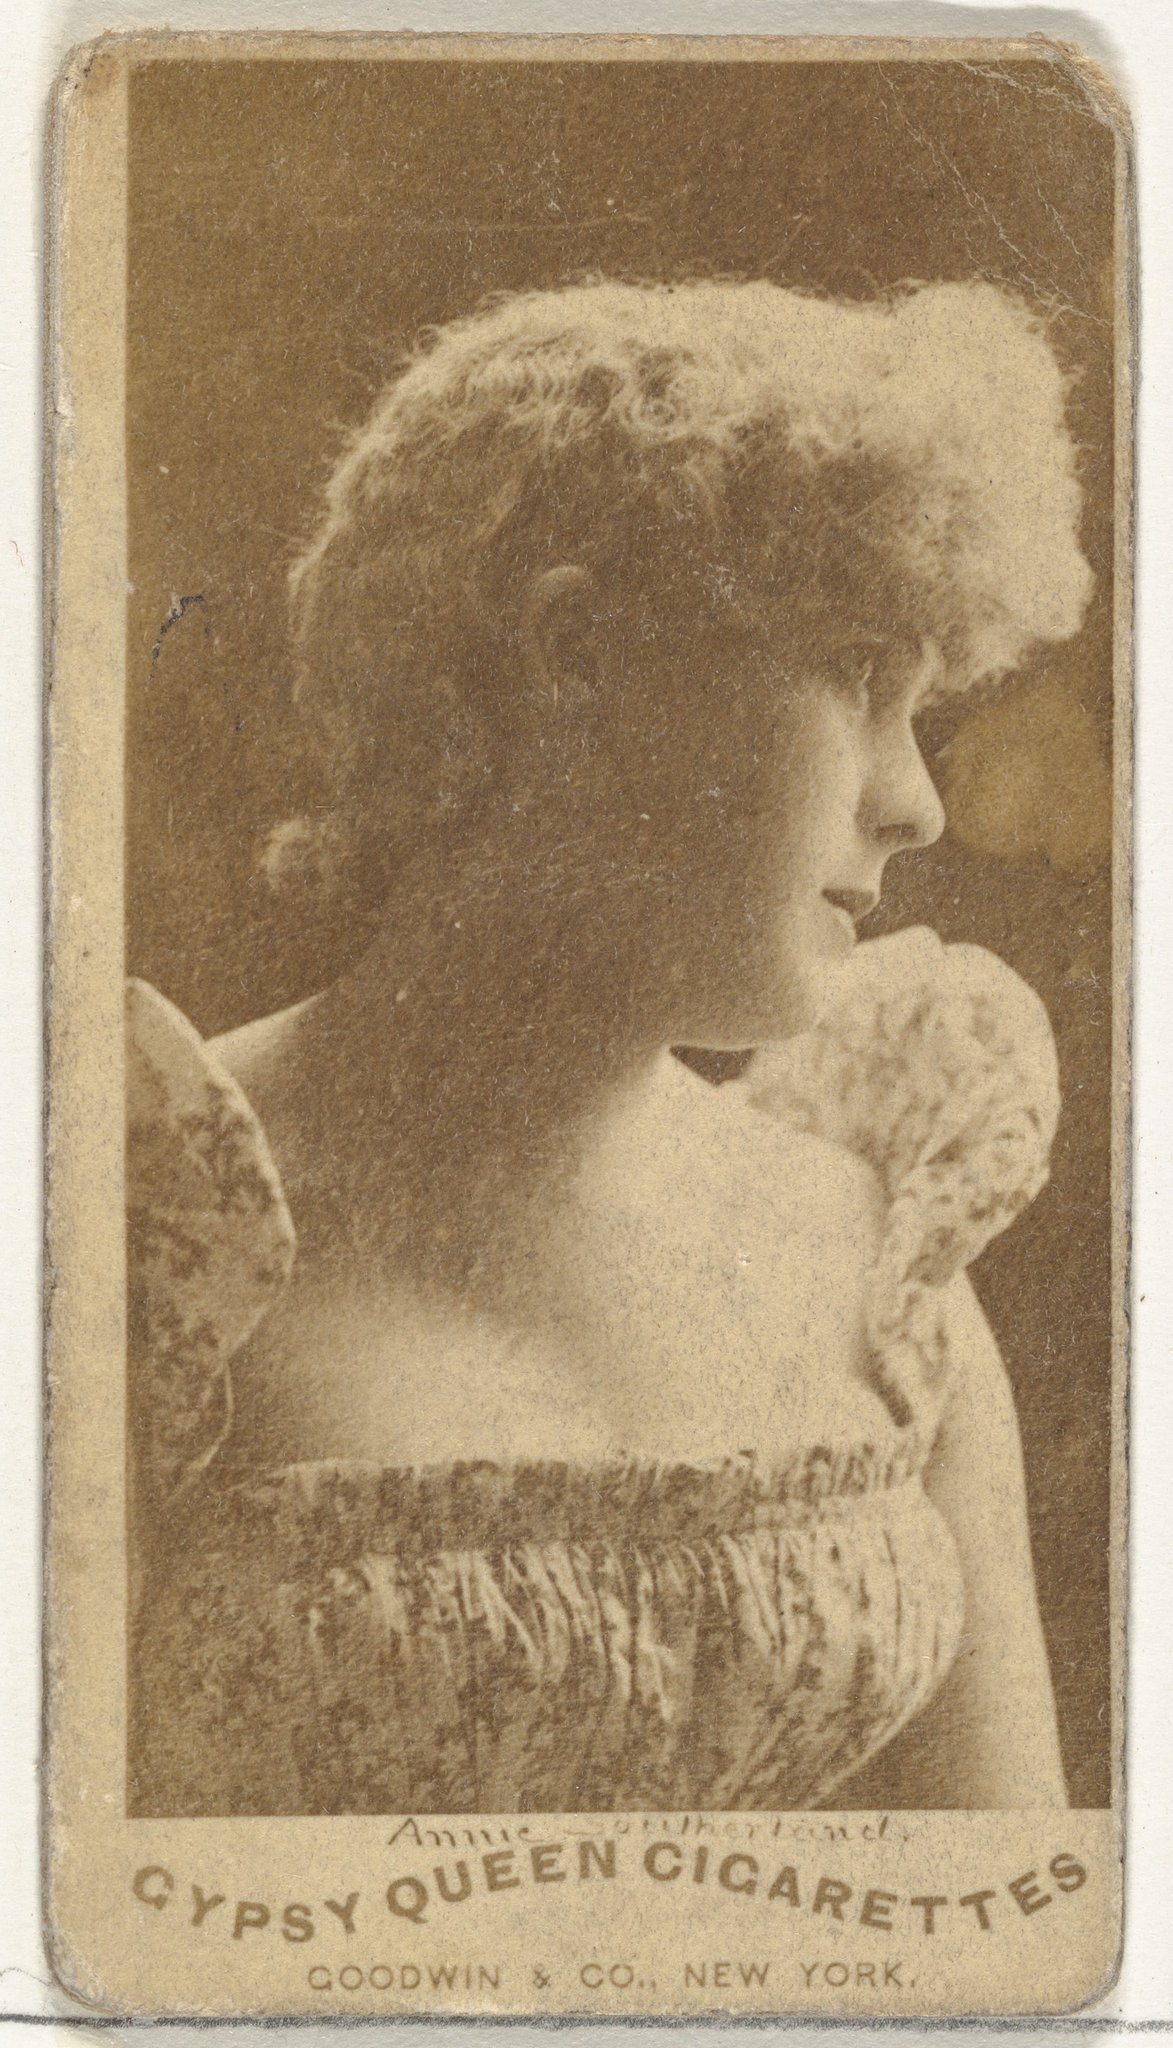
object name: photograph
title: Annie Southerland, from the Actors and Actresses series (N171) for Gypsy Queen Cigarettes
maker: goodwin & company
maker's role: publisher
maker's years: 1850-1950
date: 1886-1890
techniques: albumen silver print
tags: women,actresses